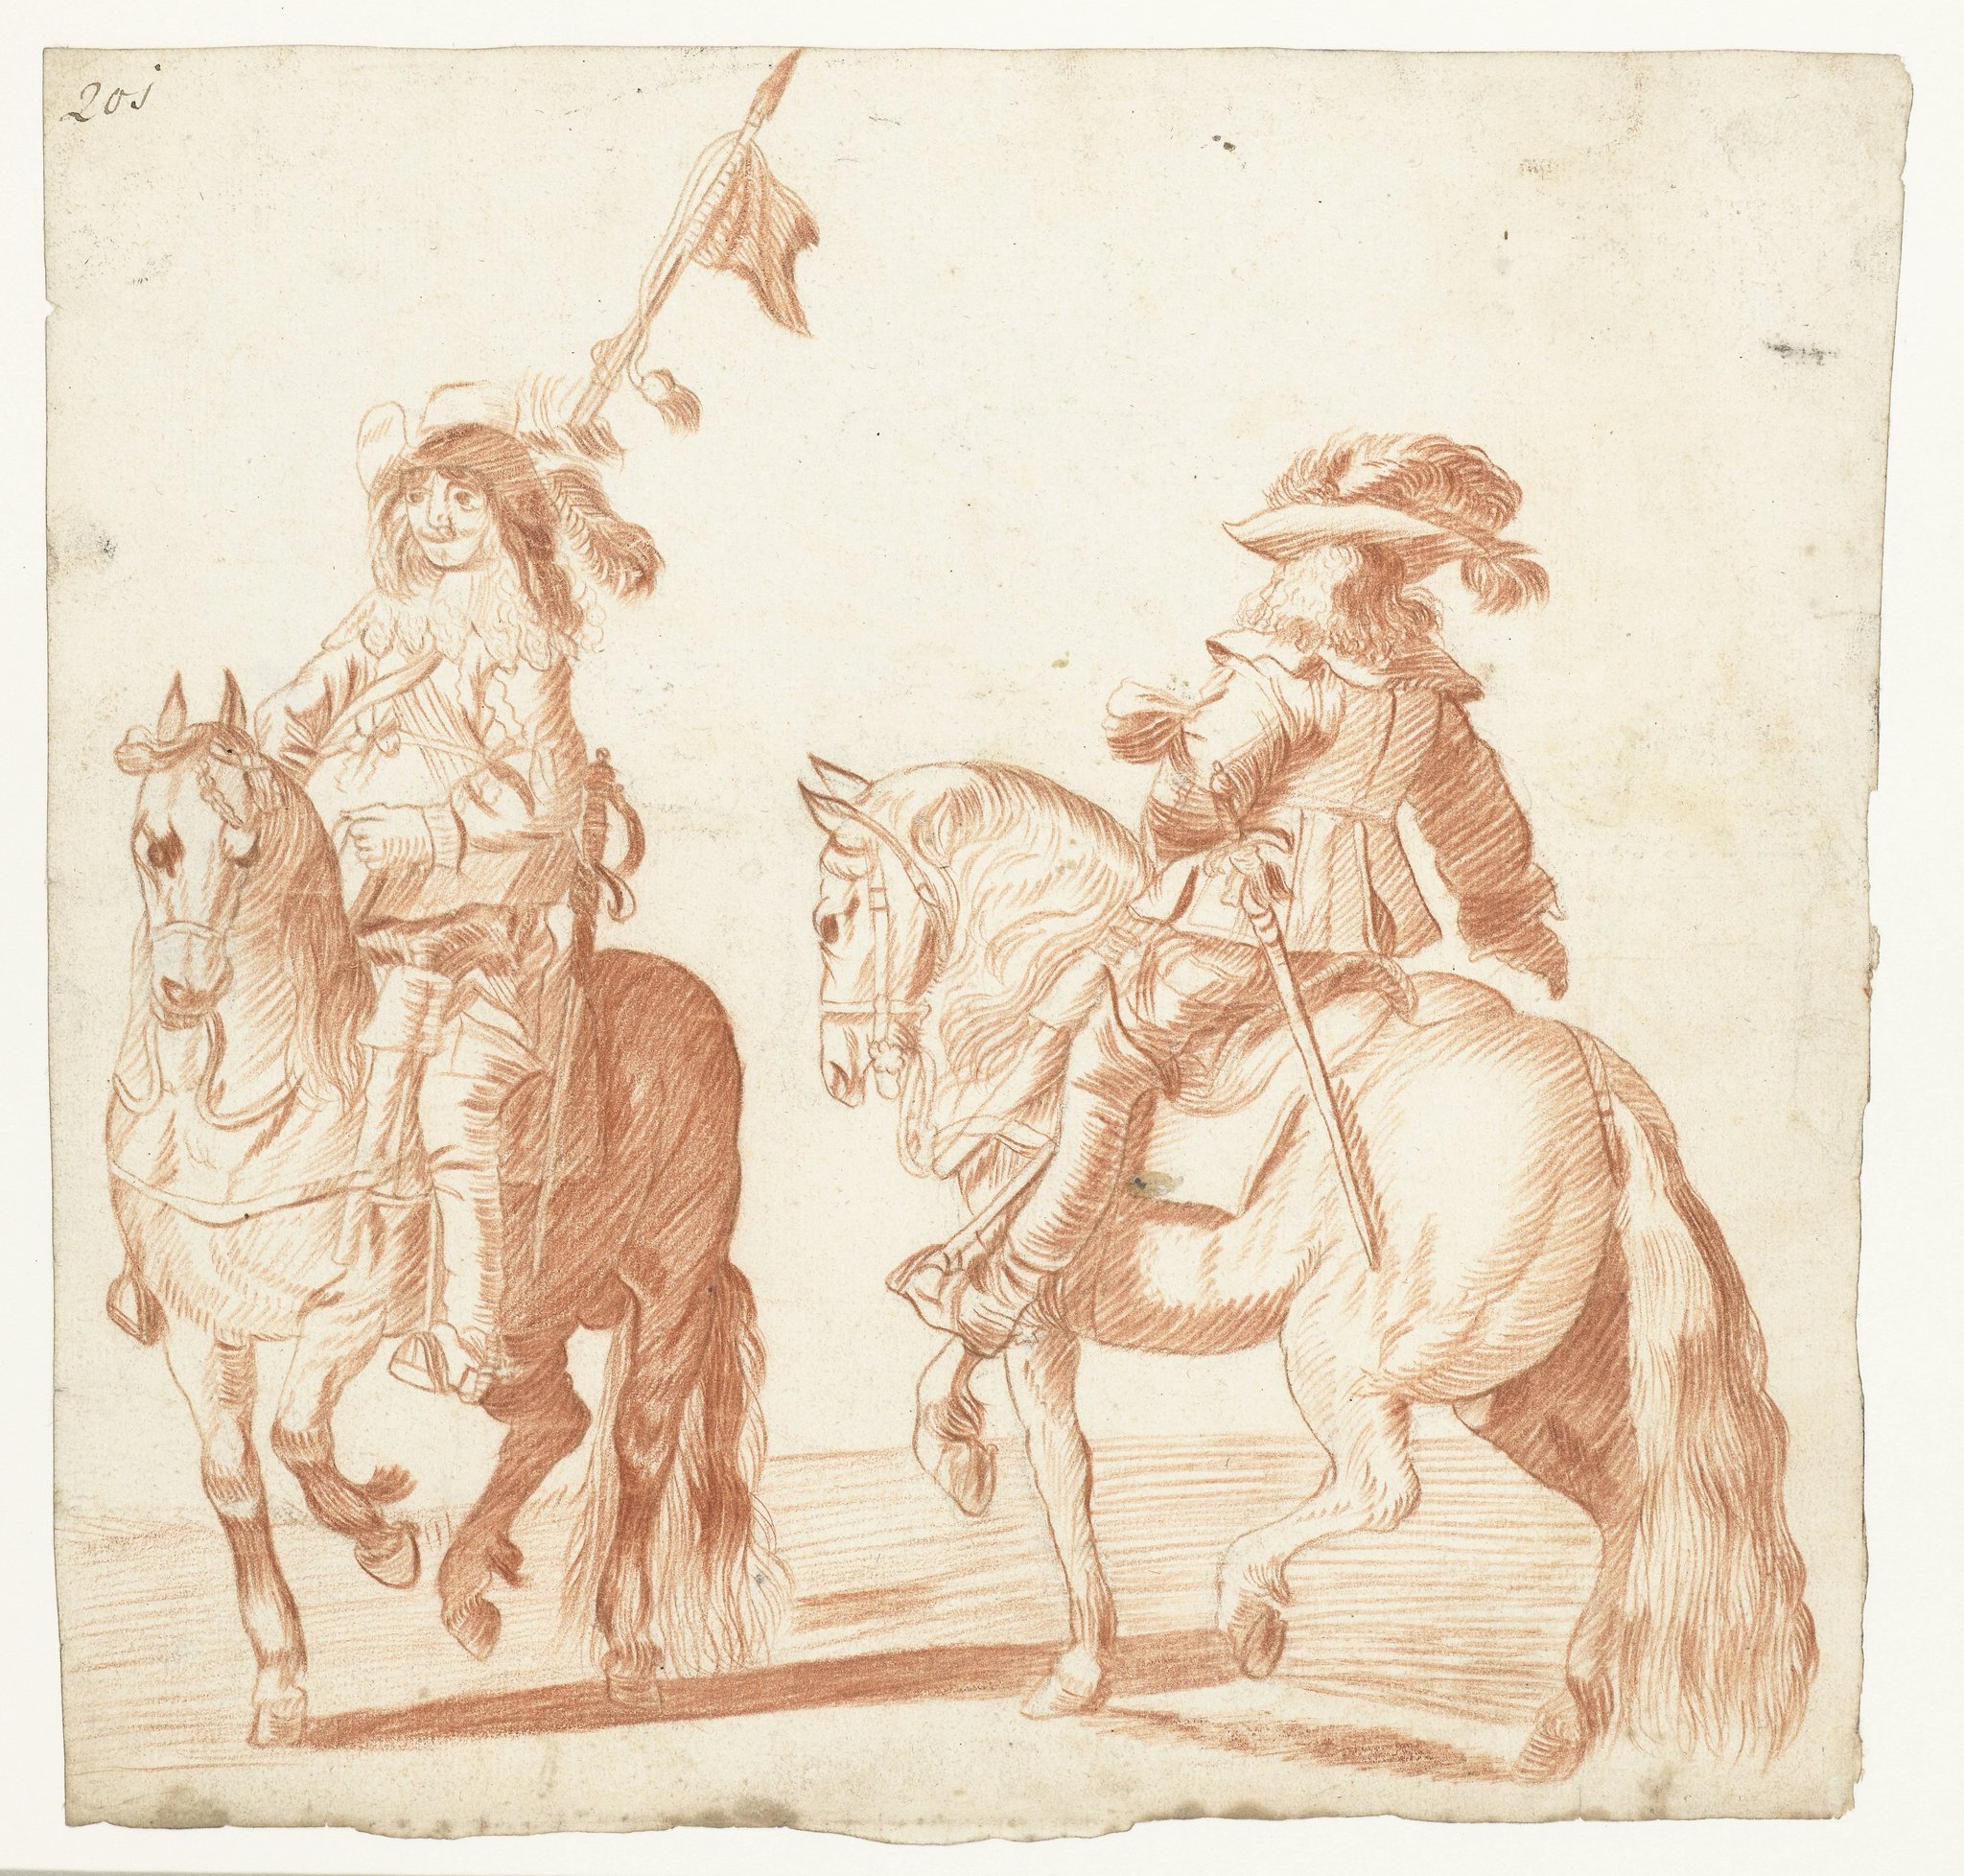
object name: drawing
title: Twee ruiters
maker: moses ter borch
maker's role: draughtsman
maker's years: 1645-1667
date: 1656-1657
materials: chalk, paper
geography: zwolle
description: Kopie naar nr. 4 uit serie van Pieter Nolpe met zes etsen van de Intocht van Maria de Medici te Amsterdam.